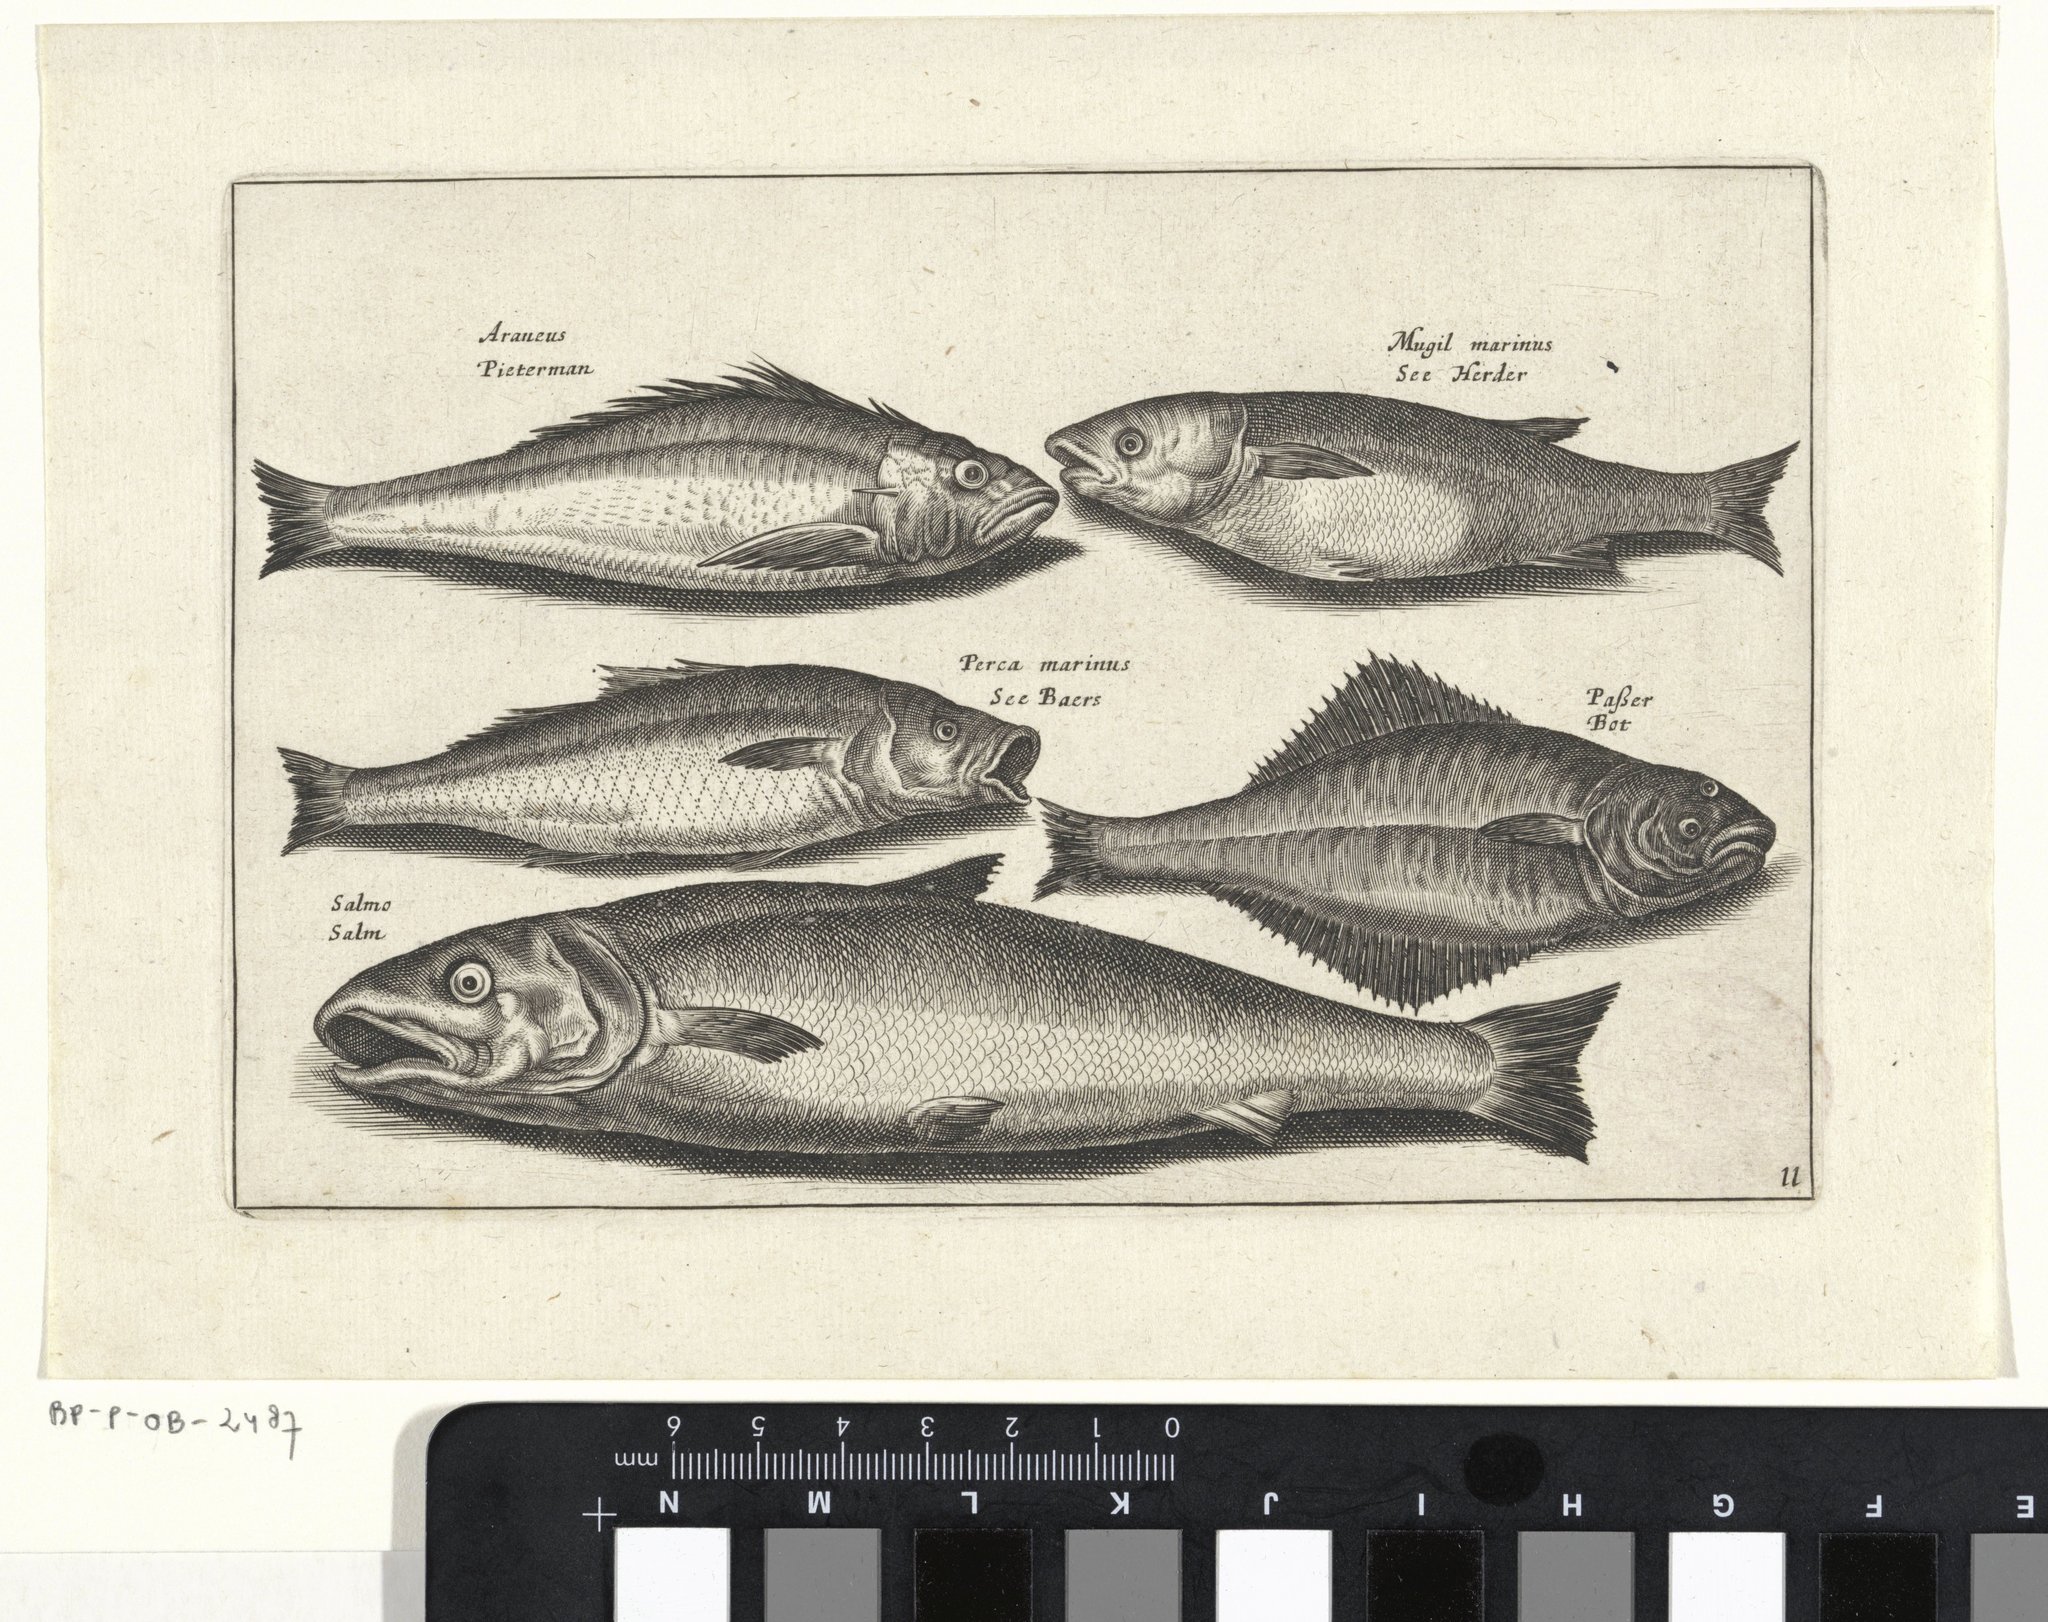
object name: print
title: Piscium Vivae Icones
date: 1634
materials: paper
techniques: engraving, etching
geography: amsterdam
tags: fishes, bony fishes: salmon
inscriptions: collector's mark: Lugt 240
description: Een bot, een zeebaars, een zalm en drie andere vissen. Elke vis is voorzien van zijn naam. De prent maakt deel uit van een serie met vissen als onderwerp.